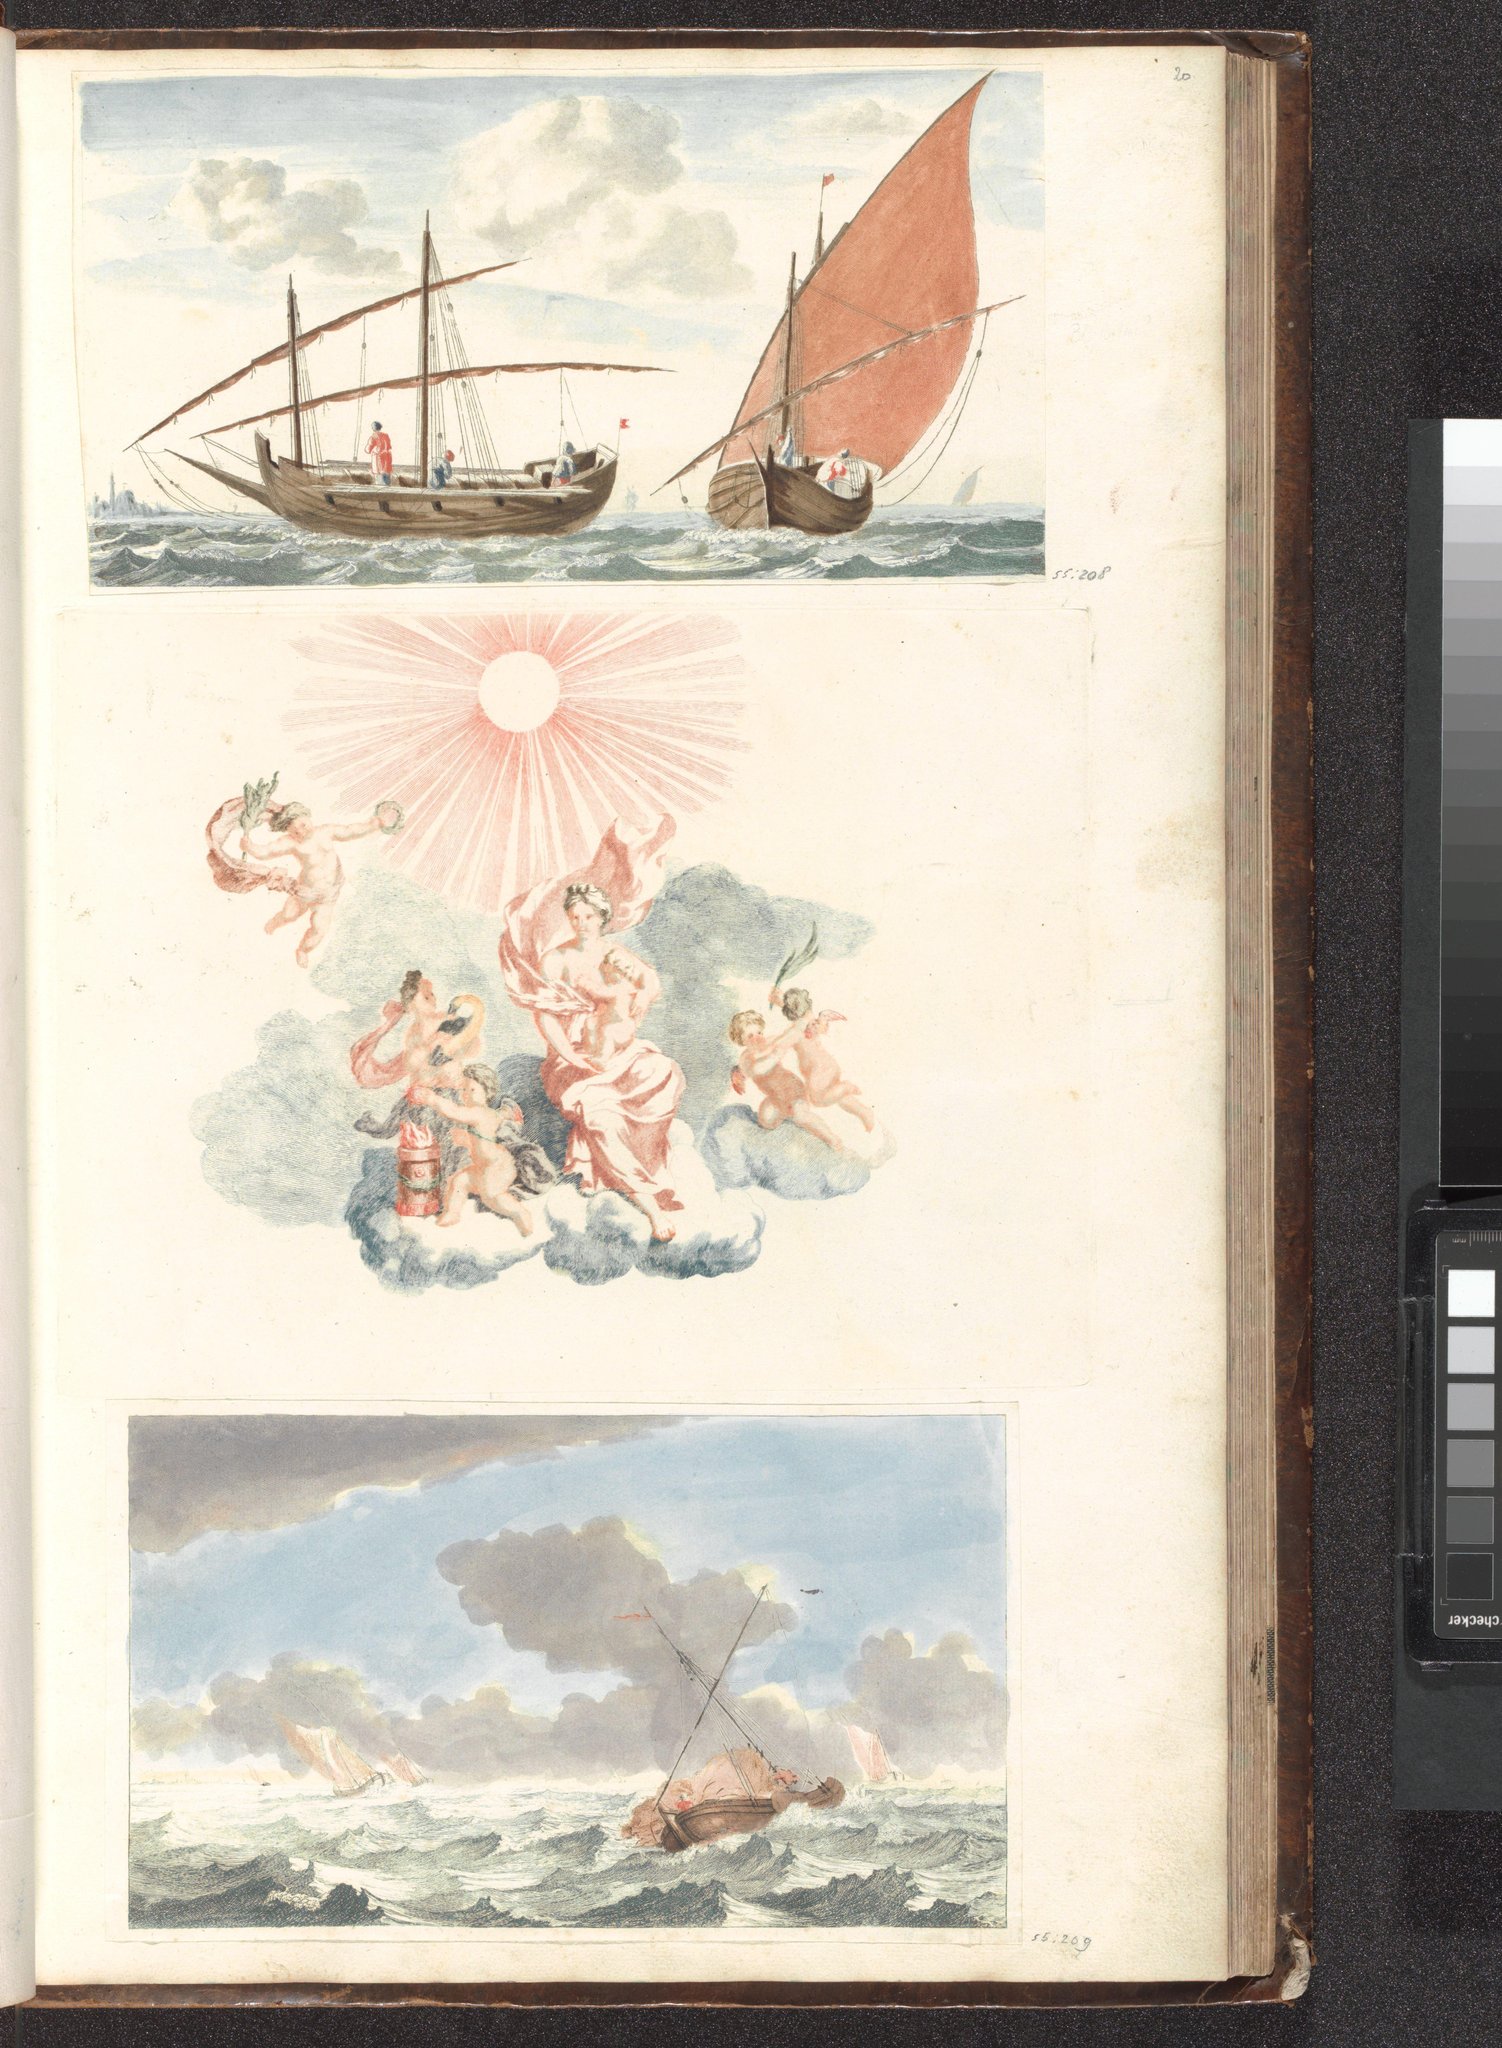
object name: print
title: Strijken van het zeil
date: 1665-1698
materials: paper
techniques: etching, hand coloring, lithography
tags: sailing-ship, sailing-boat, sea (seascape)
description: Twee mannen strijken het zeil van een platbodem. Op de achtergrond links een stad en andere schepen. Deze prent maakt deel uit van een album.